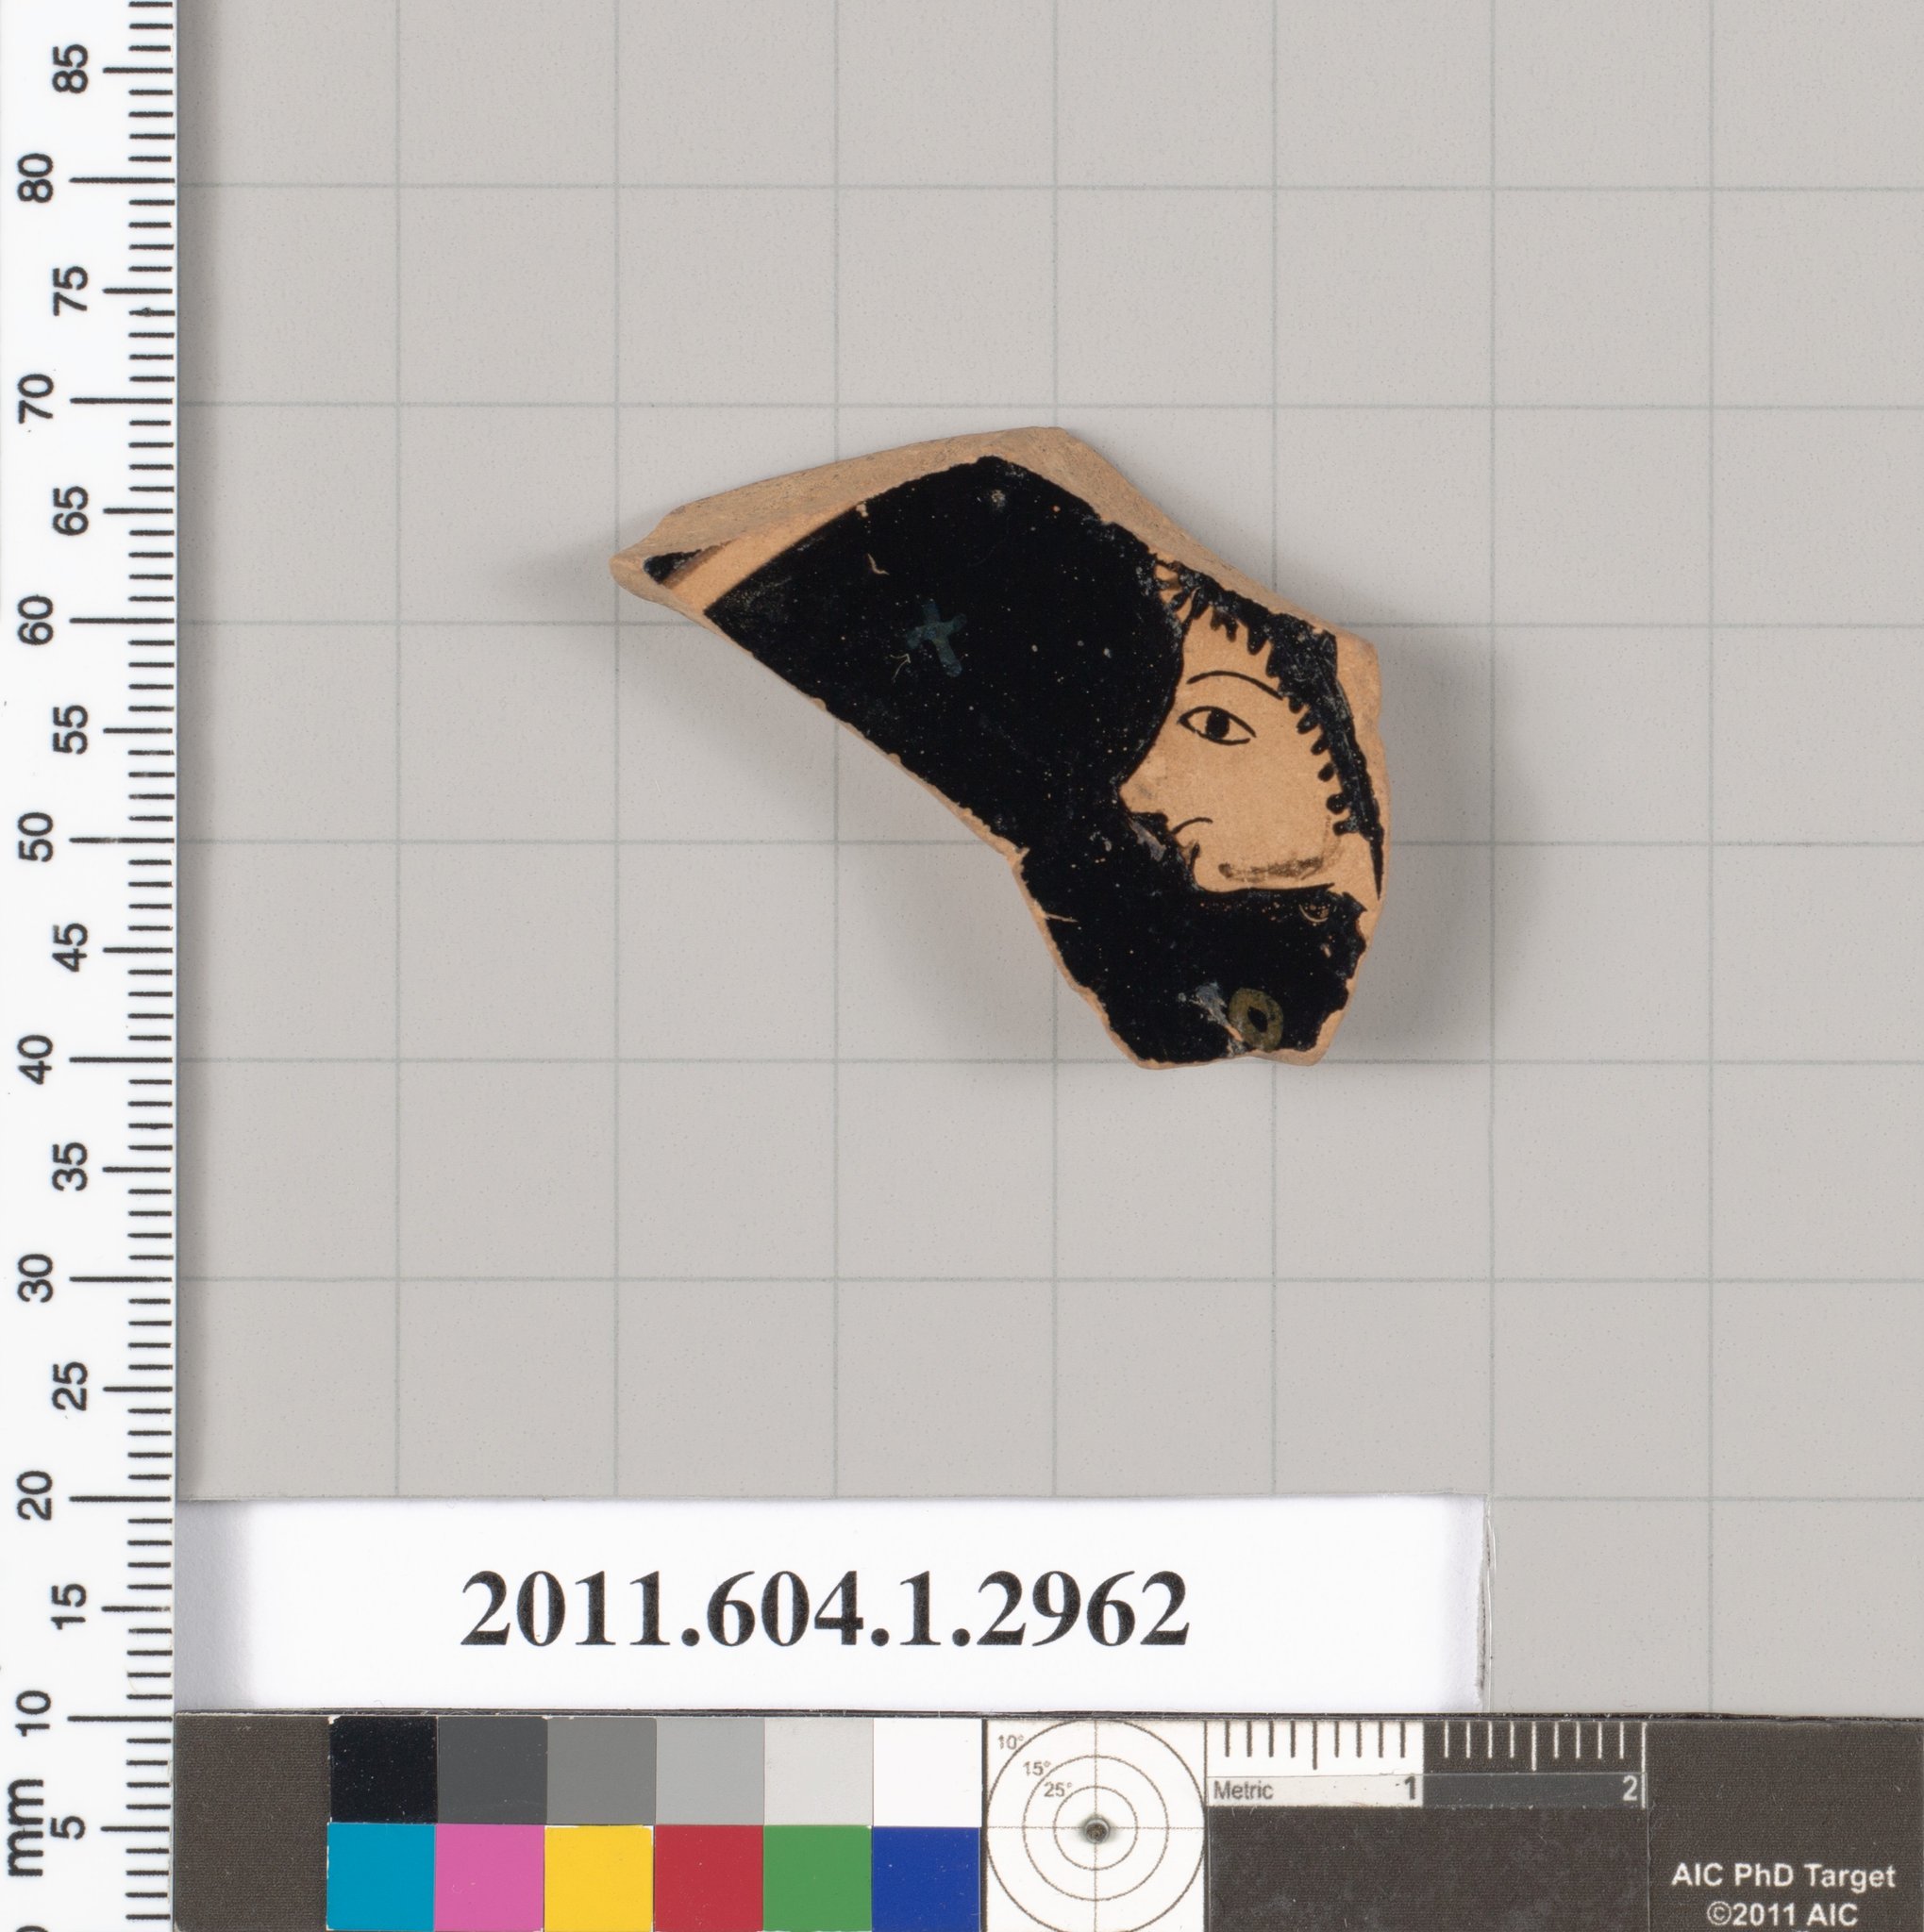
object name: kylix fragment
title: Terracotta fragment of a kylix (drinking cup)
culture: greek, attic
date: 520-500 BCE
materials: terracotta